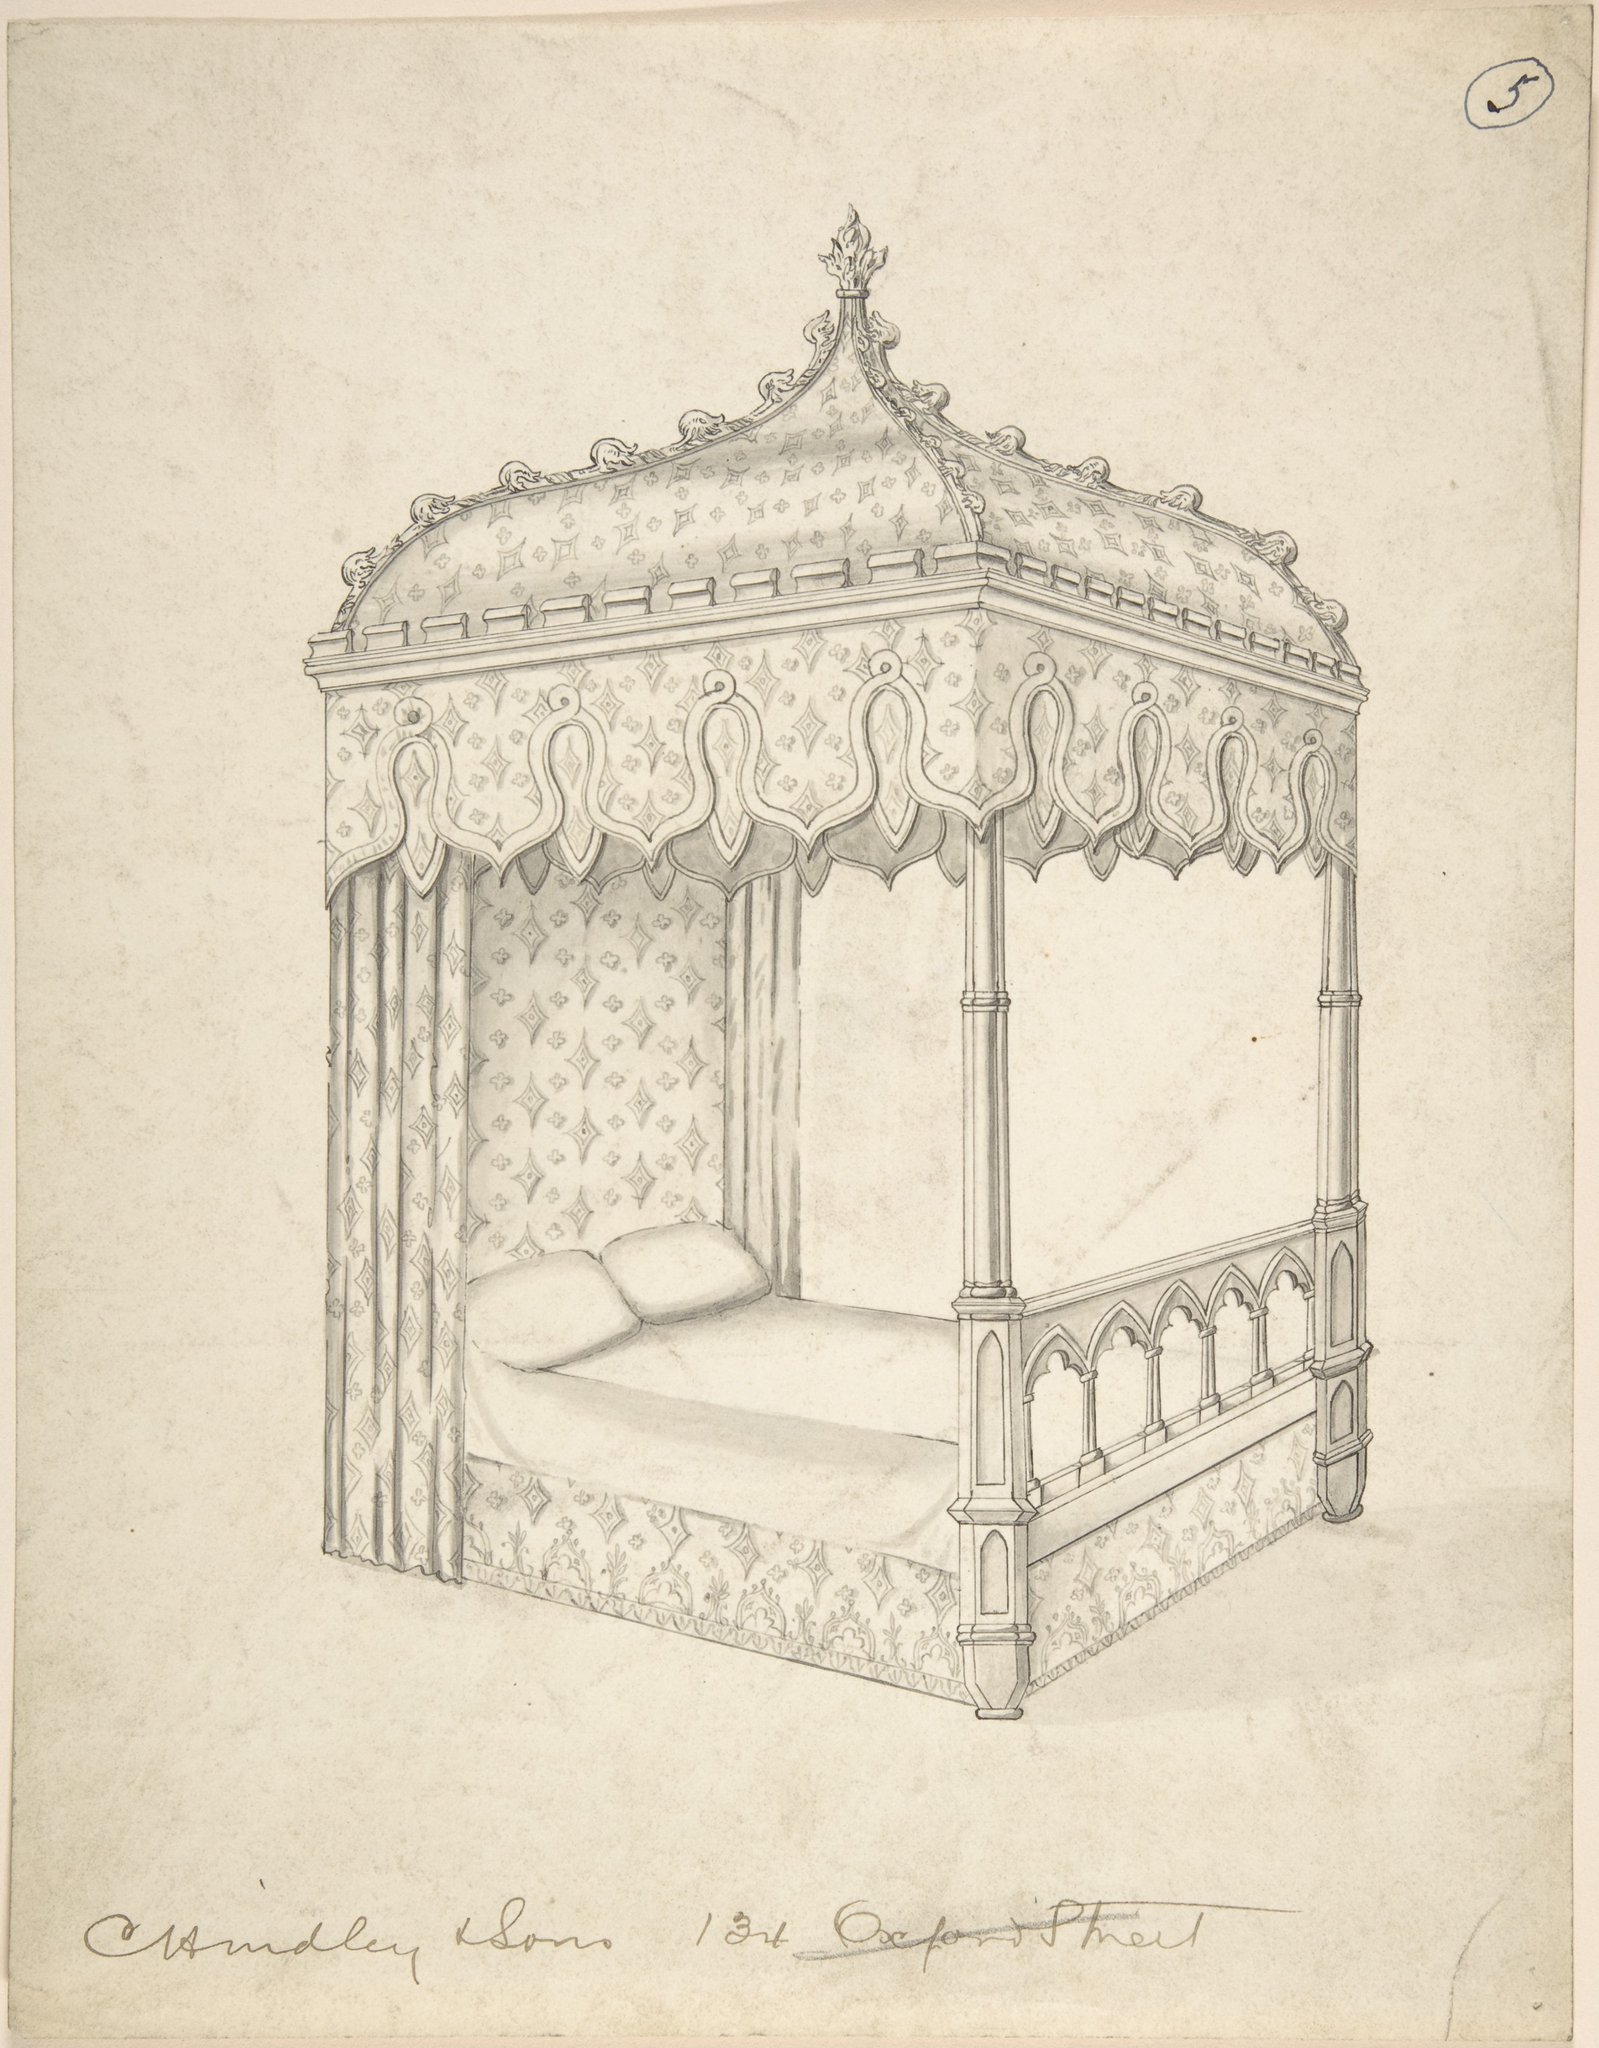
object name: drawing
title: Design for a Gothic Bed with Canopy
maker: charles hindley and sons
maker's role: artist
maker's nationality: british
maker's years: 1841-1917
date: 1841-1884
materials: ink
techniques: pen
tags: beds